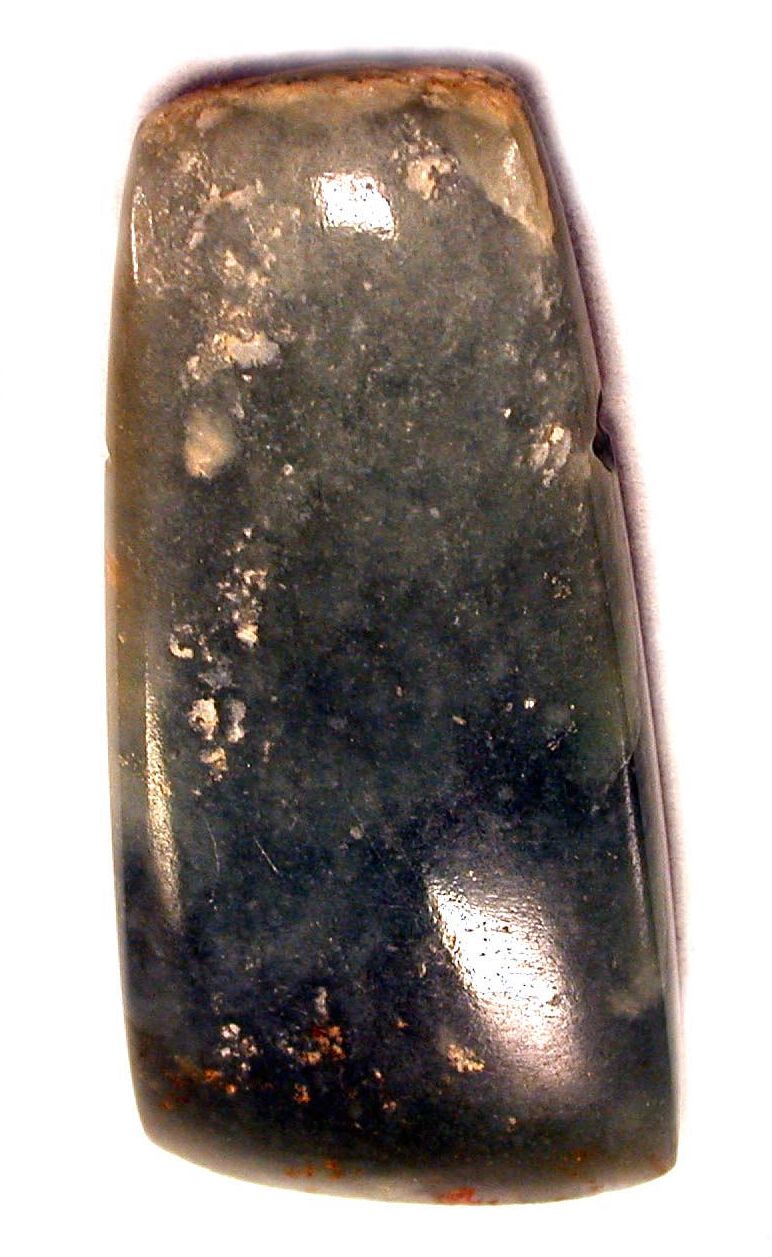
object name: pendant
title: Celt-Form Pendant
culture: maya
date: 1501-1600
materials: stone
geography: guatemala